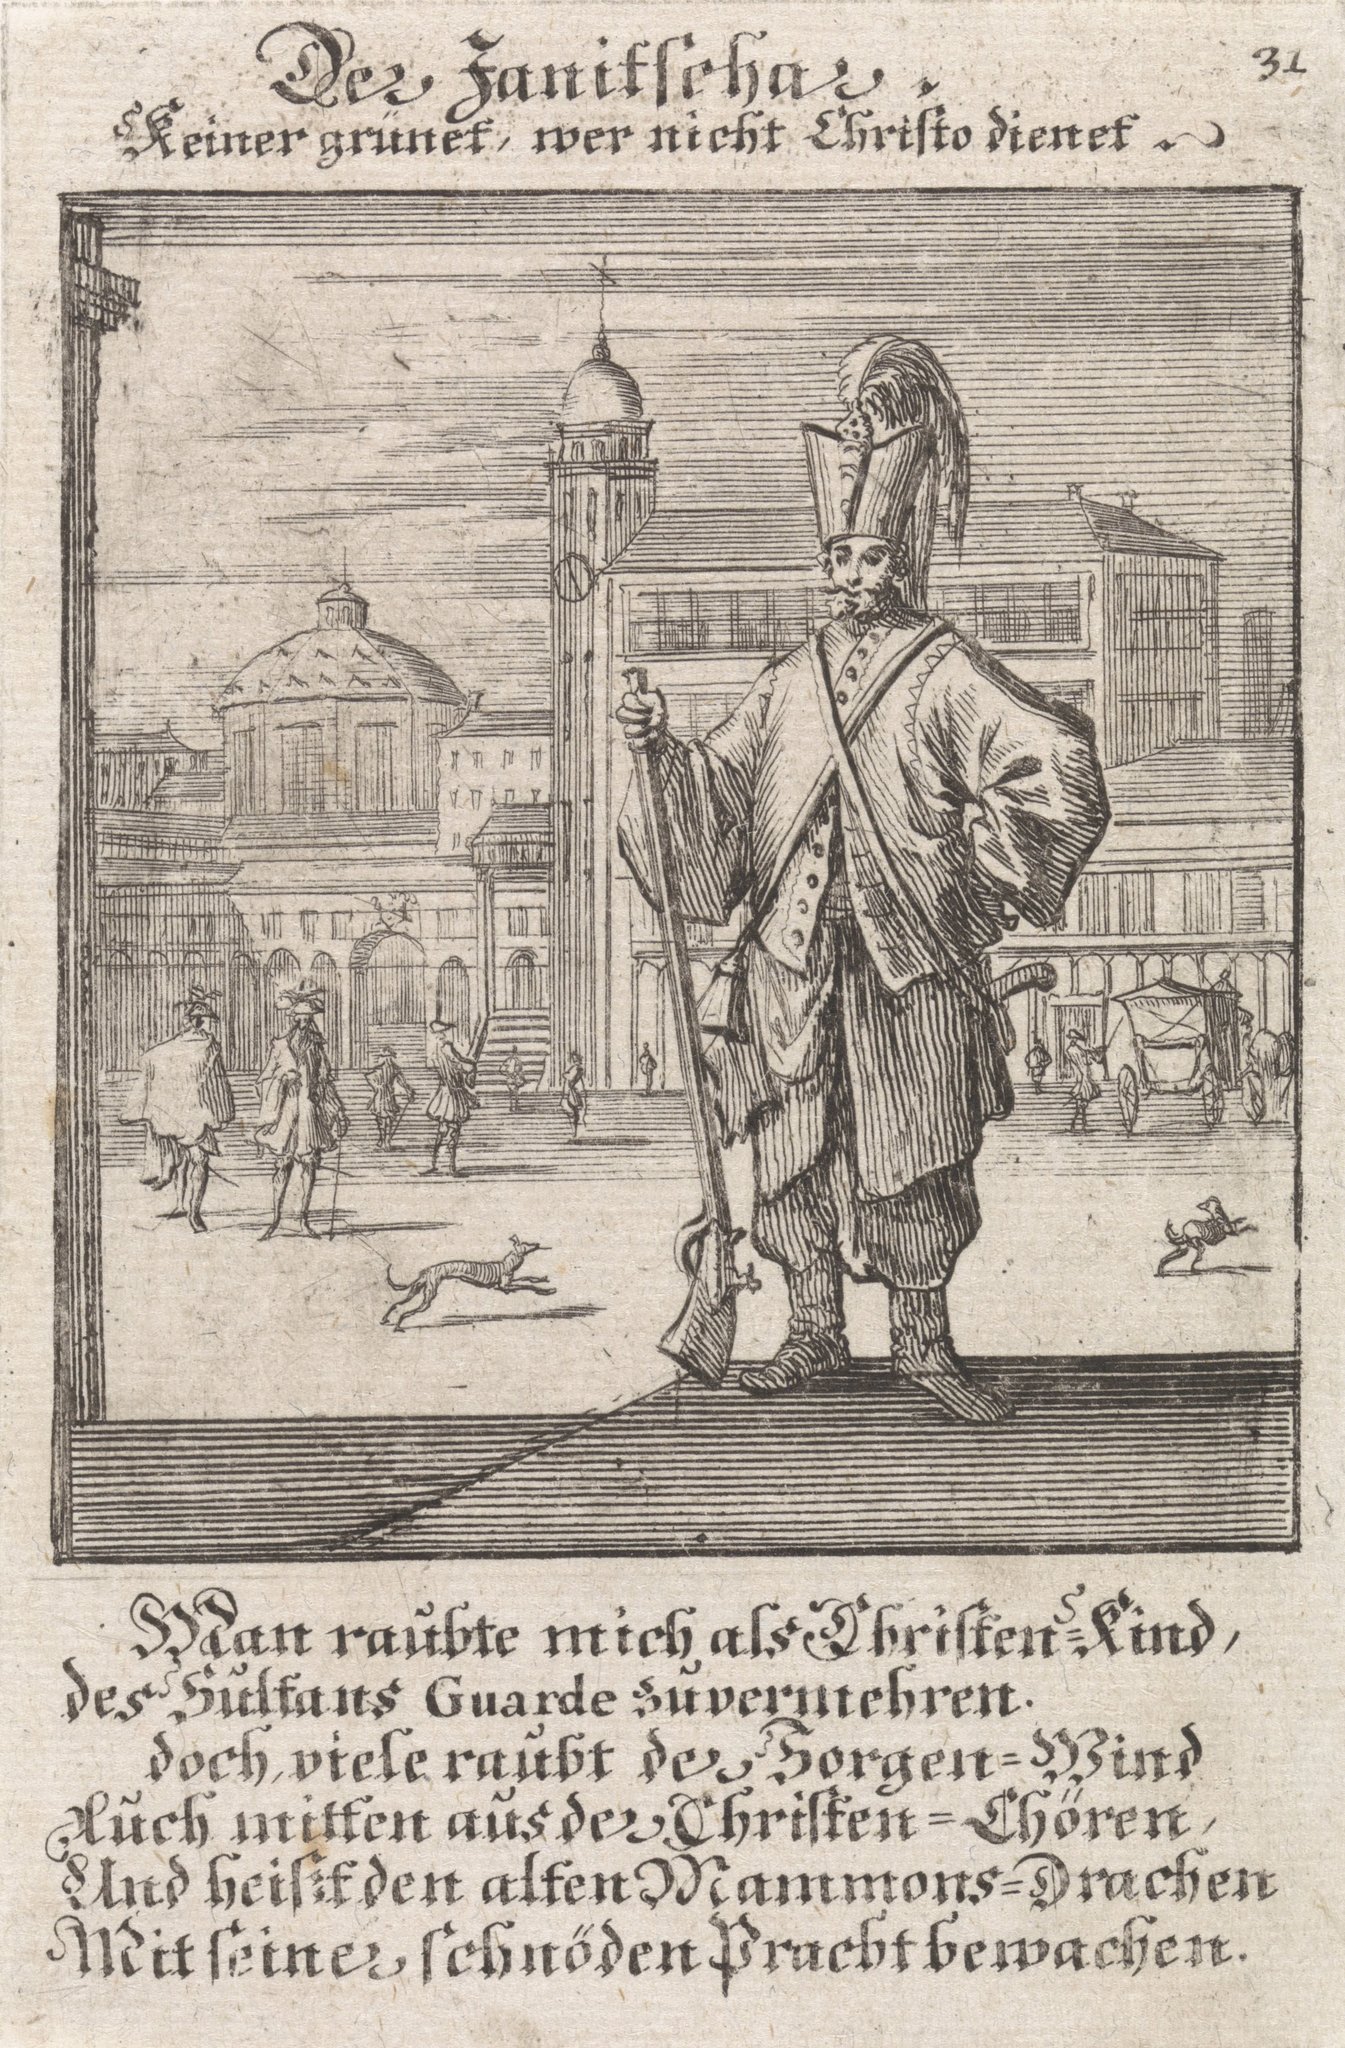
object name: print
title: Turks infanteriesoldaat (Janitsaar)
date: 1711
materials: paper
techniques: etching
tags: asiatic races and peoples: turks, land forces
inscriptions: collector's mark: Lugt 2228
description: Illustratie uit: Sancta Clara, Abraham à. Etwas für Alle, das ist: Eine kurtze Beschreibung allerley Stands- Ambts- und Gewerbs-Persohnen (...), 3 delen (1699-1733). Würtzburg: Martin Frank Hertz, 1711, dl. II, p. 299. Het betreft hier de tweede druk van deel II.